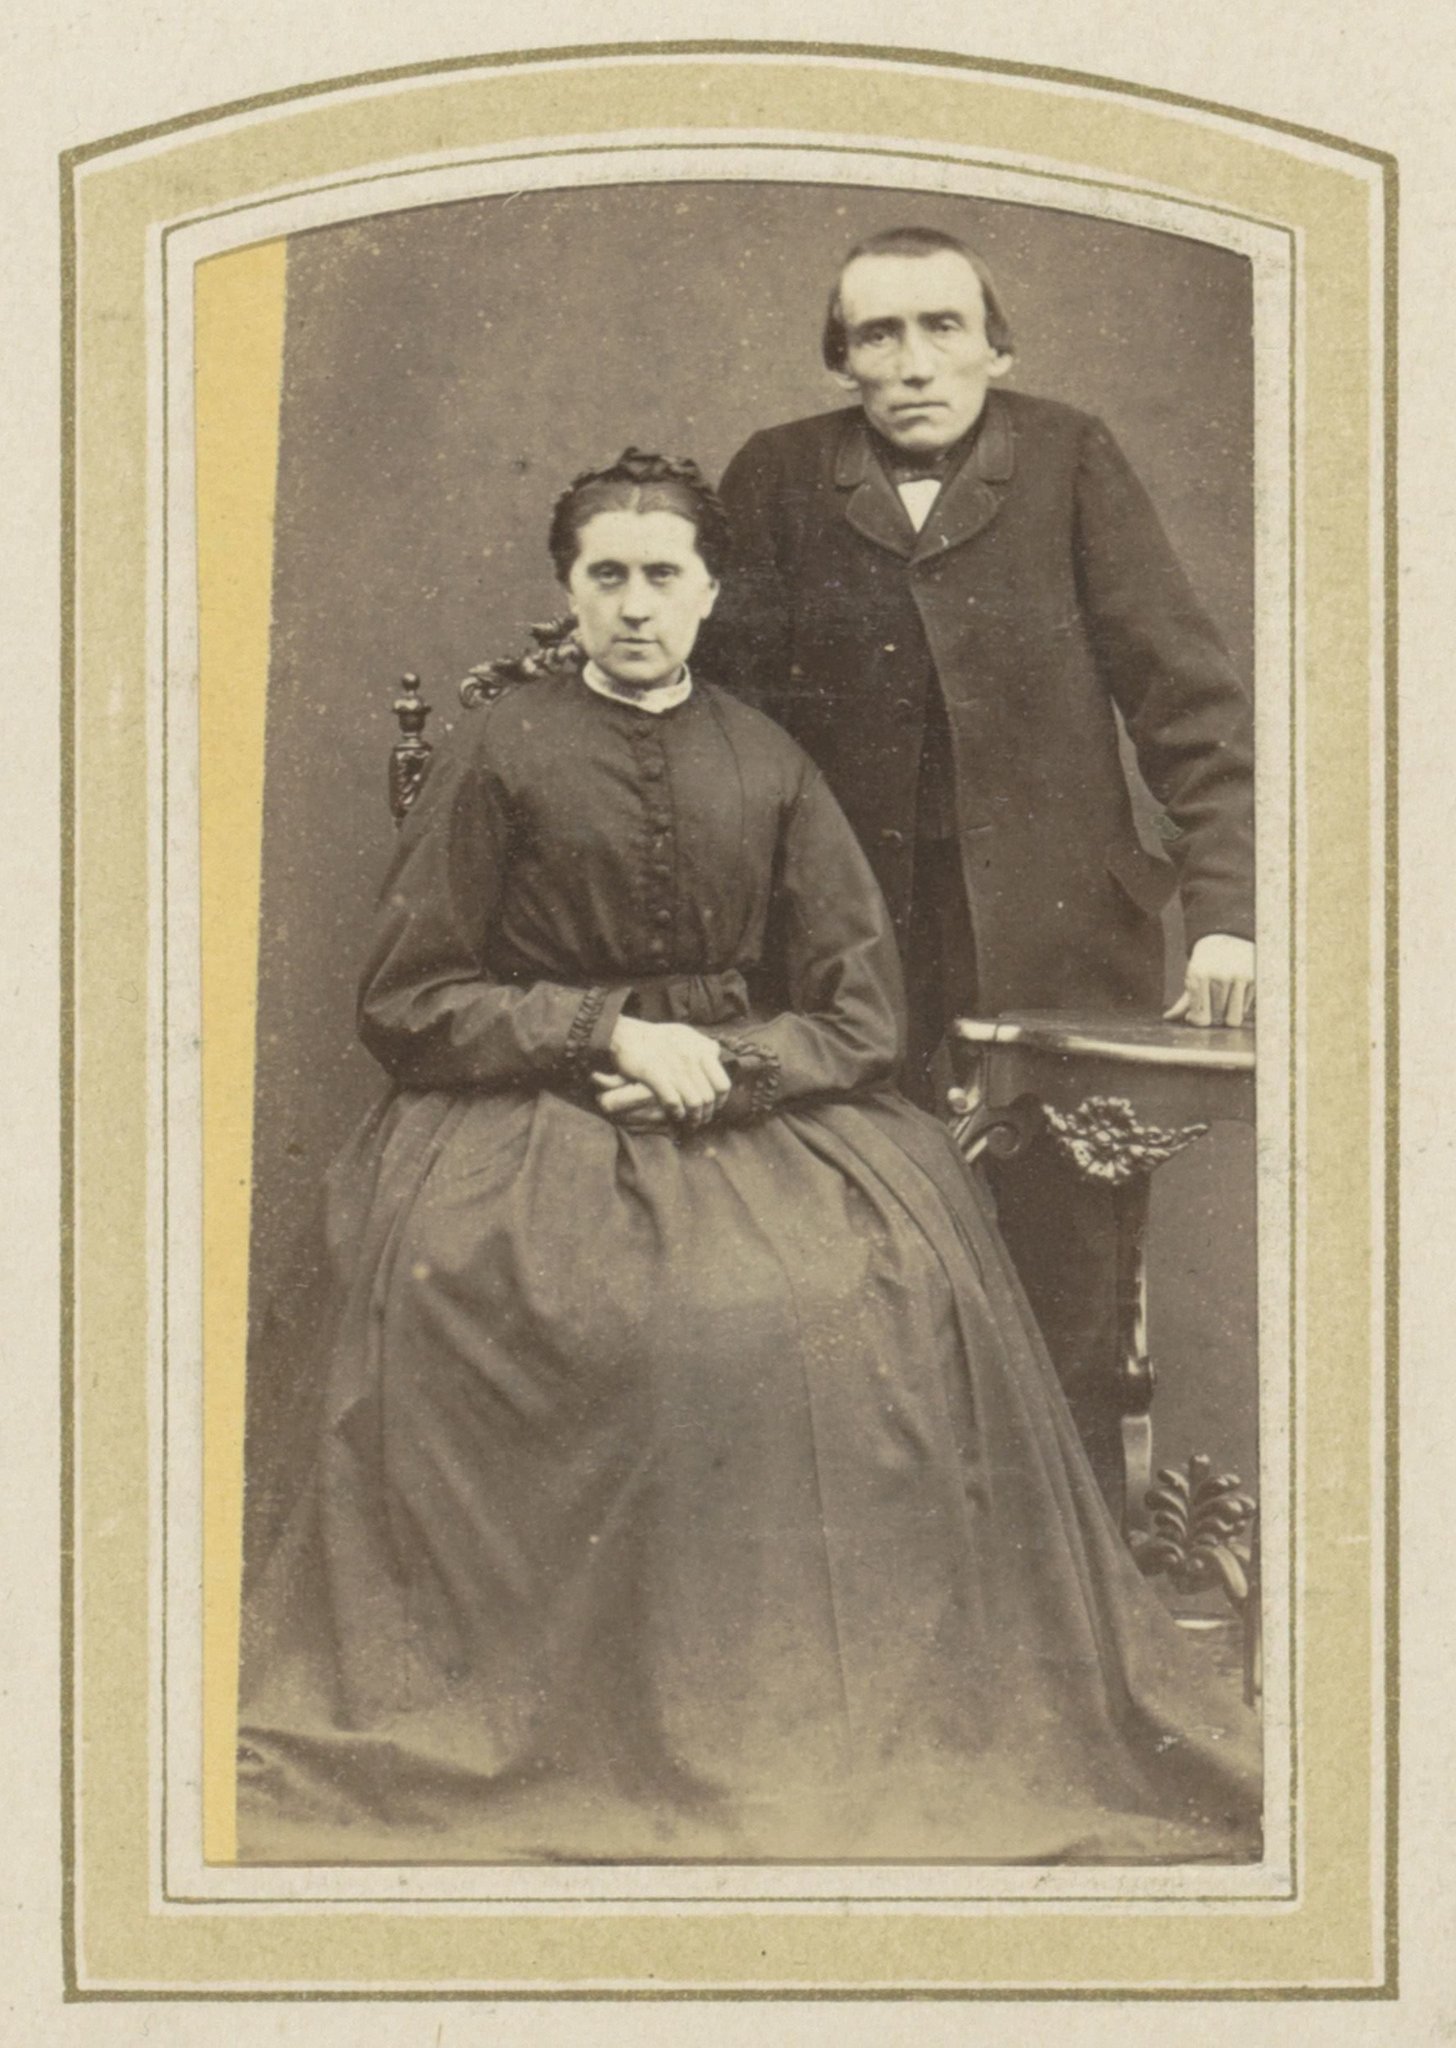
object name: carte de visite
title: Portret van een man in een lange jas en een vrouw in een jurk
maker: e. steffen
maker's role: fotograaf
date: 1860-1900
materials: cardboard, paper, photographic support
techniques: albumen print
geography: enschede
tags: studio requisites ~ photographer, historical persons, neck-gear ~ clothing, clothing for the upper part of the body, hairdress, dress, gown, coat, cape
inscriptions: address: ‘Enschedé’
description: Onderdeel van Fotoalbum van een Nederlandse familie met 168 cartes-de-visite en kabinetfoto's.